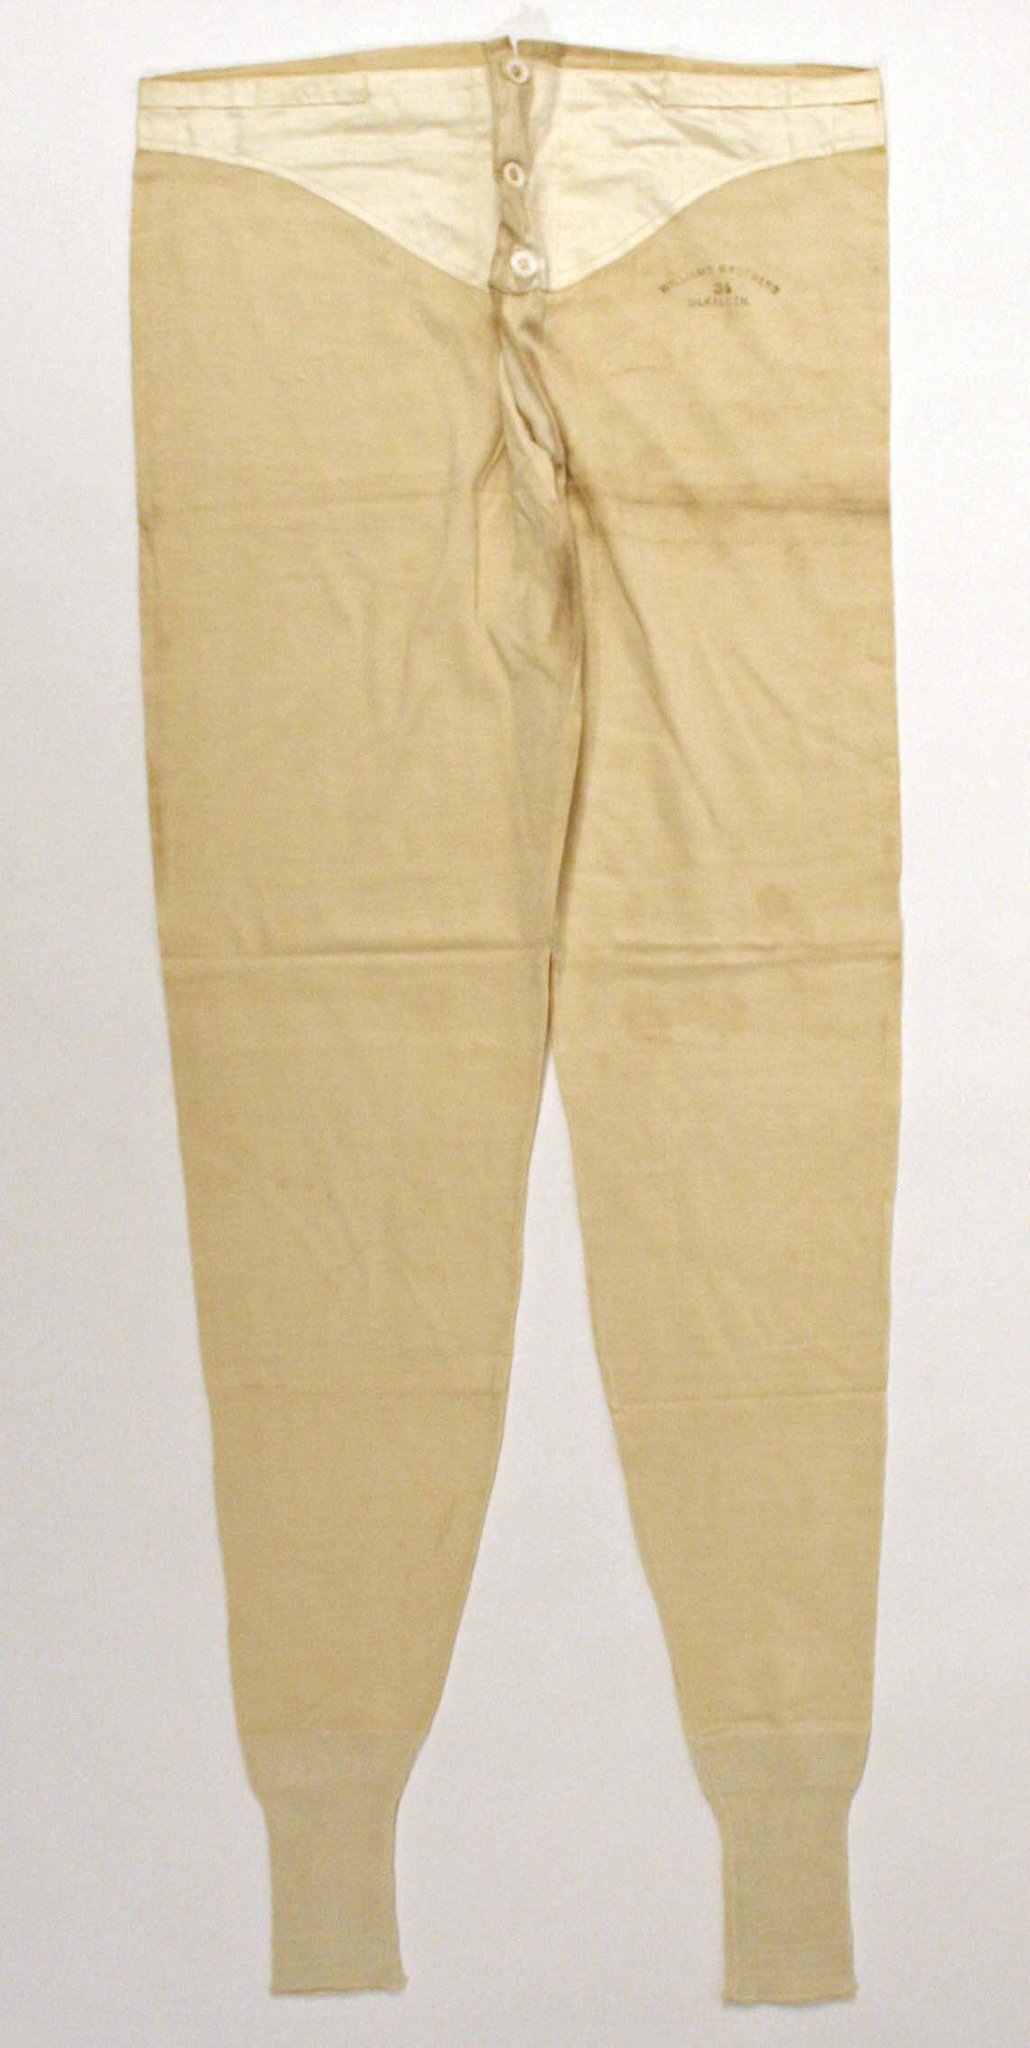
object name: drawer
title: Drawers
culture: american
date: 1890-1899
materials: cotton